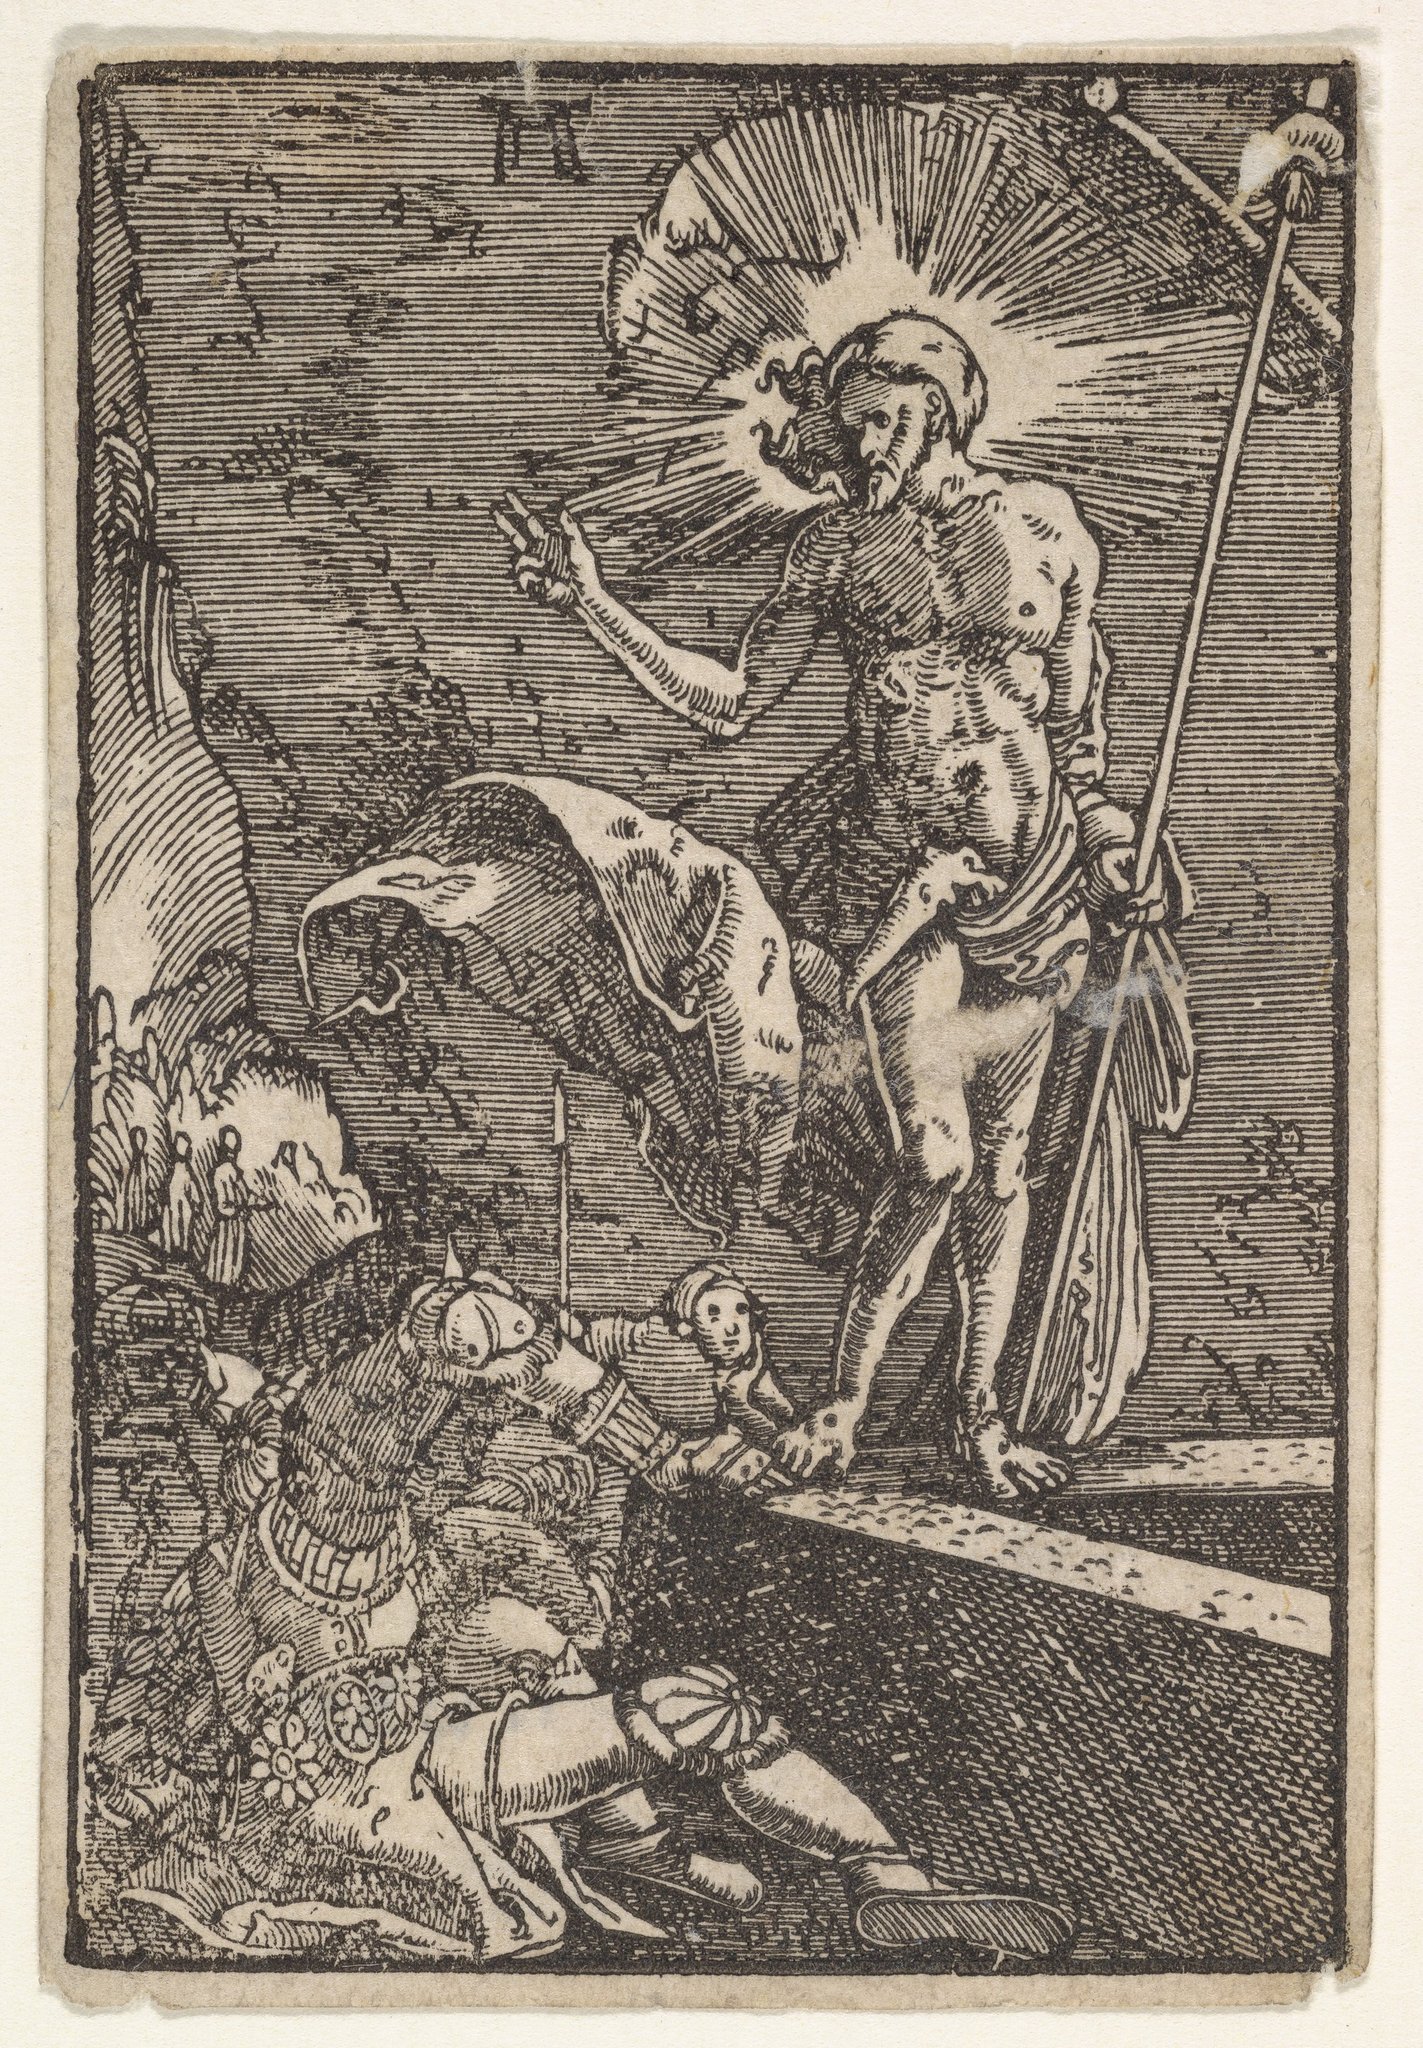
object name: print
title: The Resurrection, from "The Fall and Salvation of Mankind Through the Life and Passion of Christ"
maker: albrecht altdorfer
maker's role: artist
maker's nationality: german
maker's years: 1480-1538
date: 1513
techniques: woodcut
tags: christ